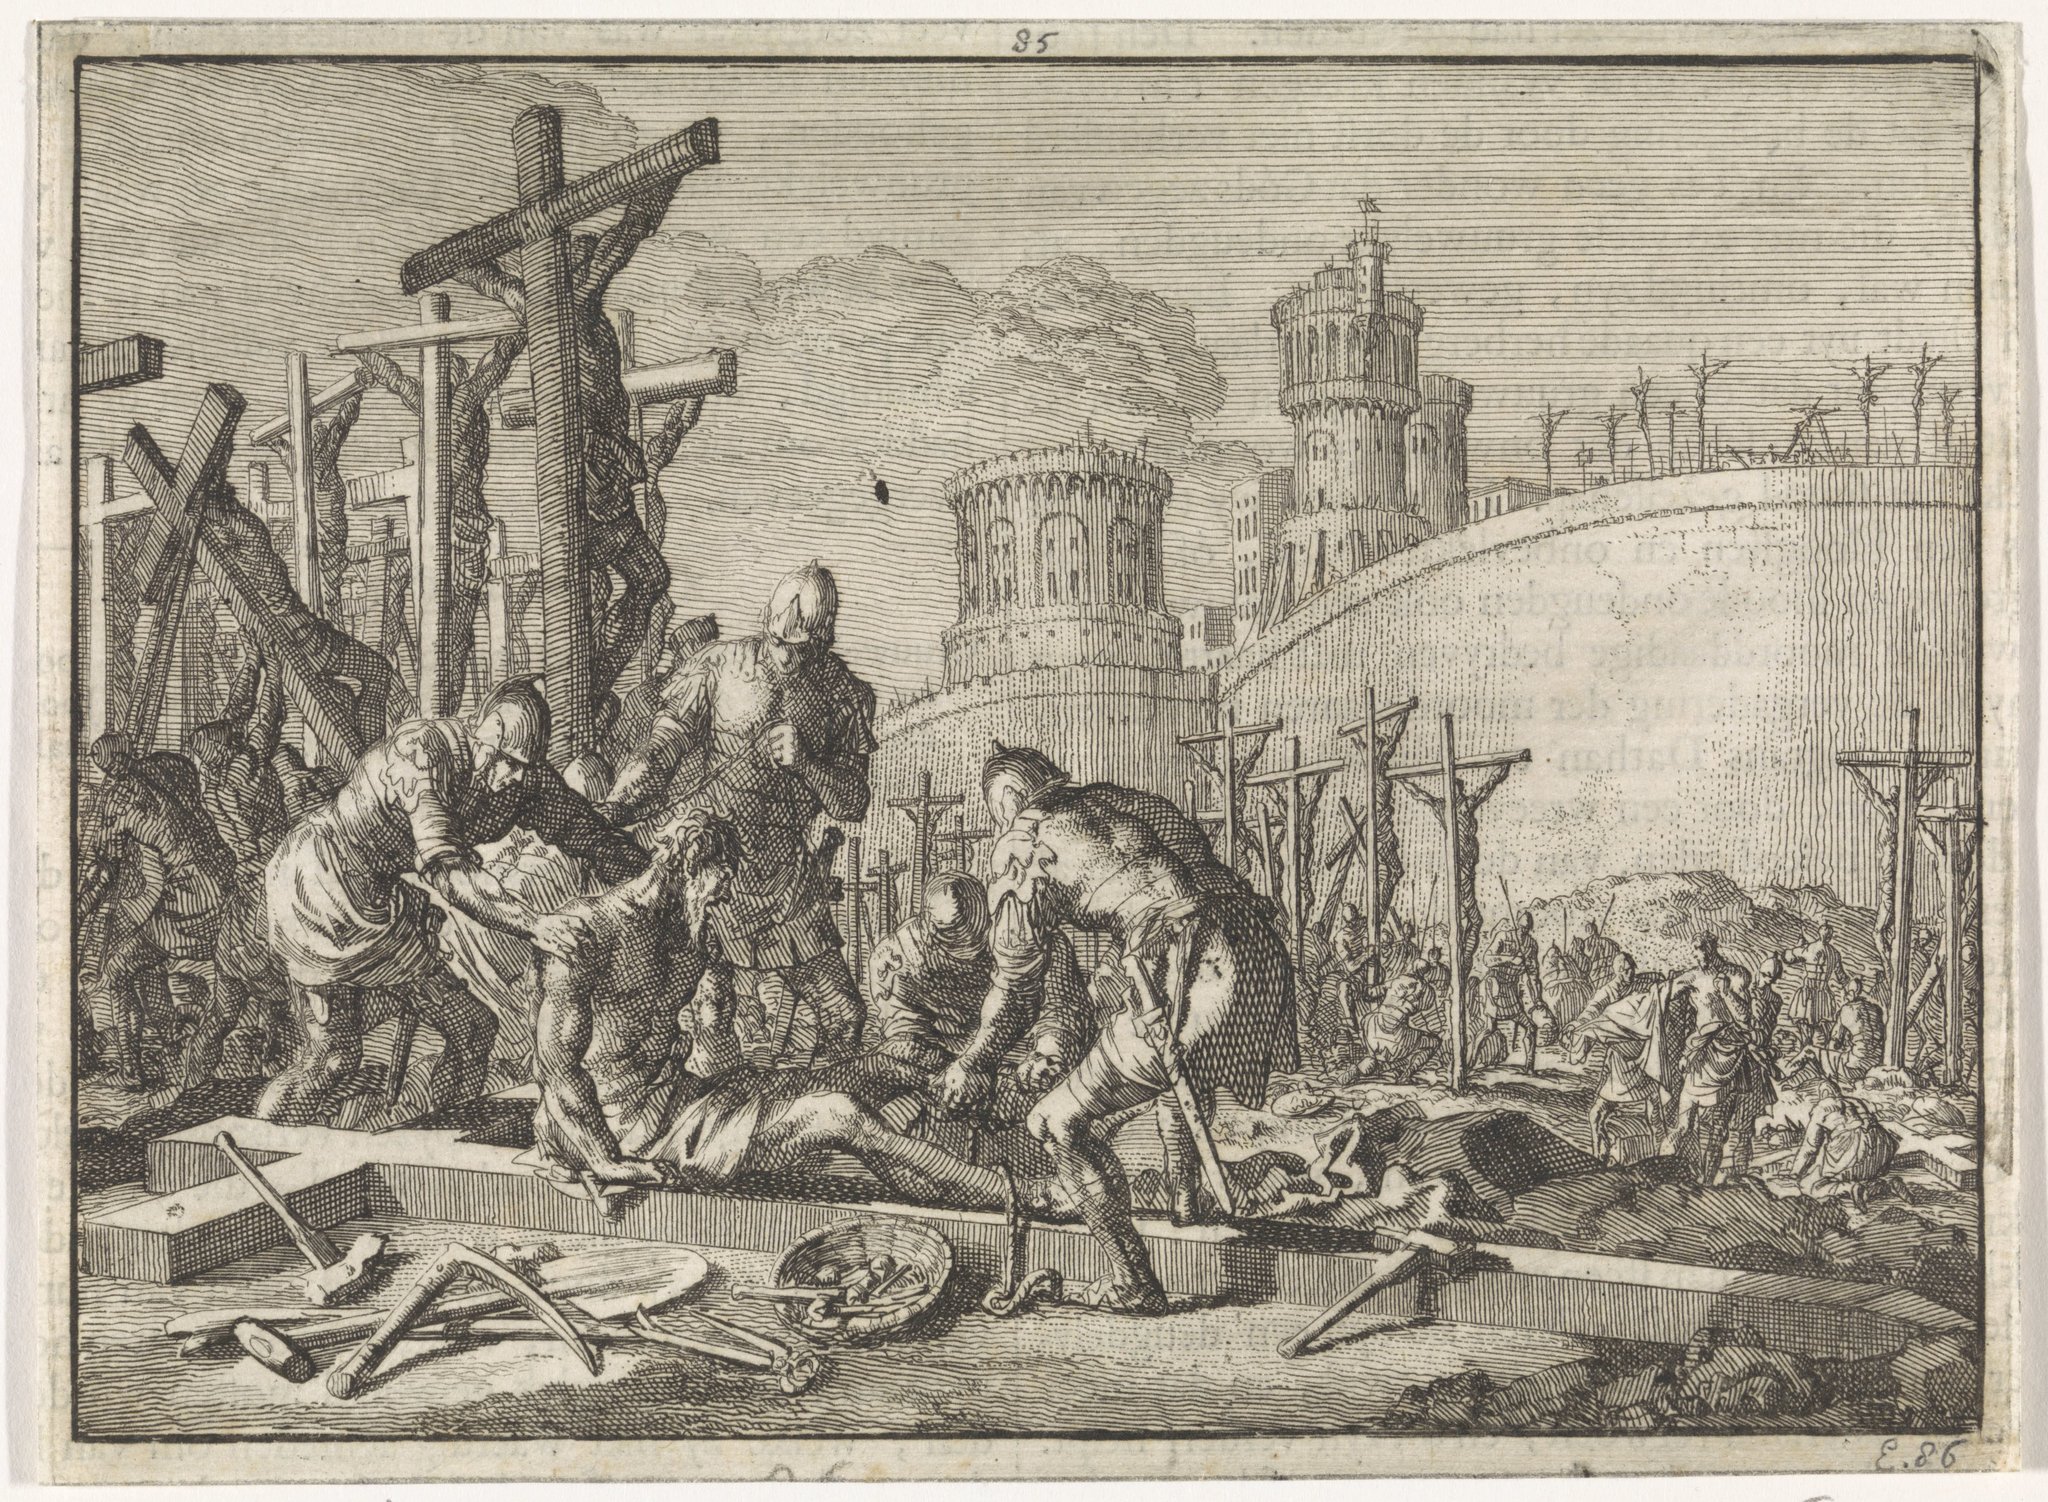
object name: print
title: Tijdens de belegering van Jeruzalem wordt een aantal gevangen Joden door de Romeinen gekruisigd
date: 1704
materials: paper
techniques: etching, letterpress printing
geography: amsterdam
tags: (military) attack, violent death by crucifixion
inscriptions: collector's mark: Lugt 2228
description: Prent opgenomen in: Josephus, Flavius. Alle de Werken, 2 delen. Amsterdam: Pieter Mortier, 1704, dl. 2, p. 86.